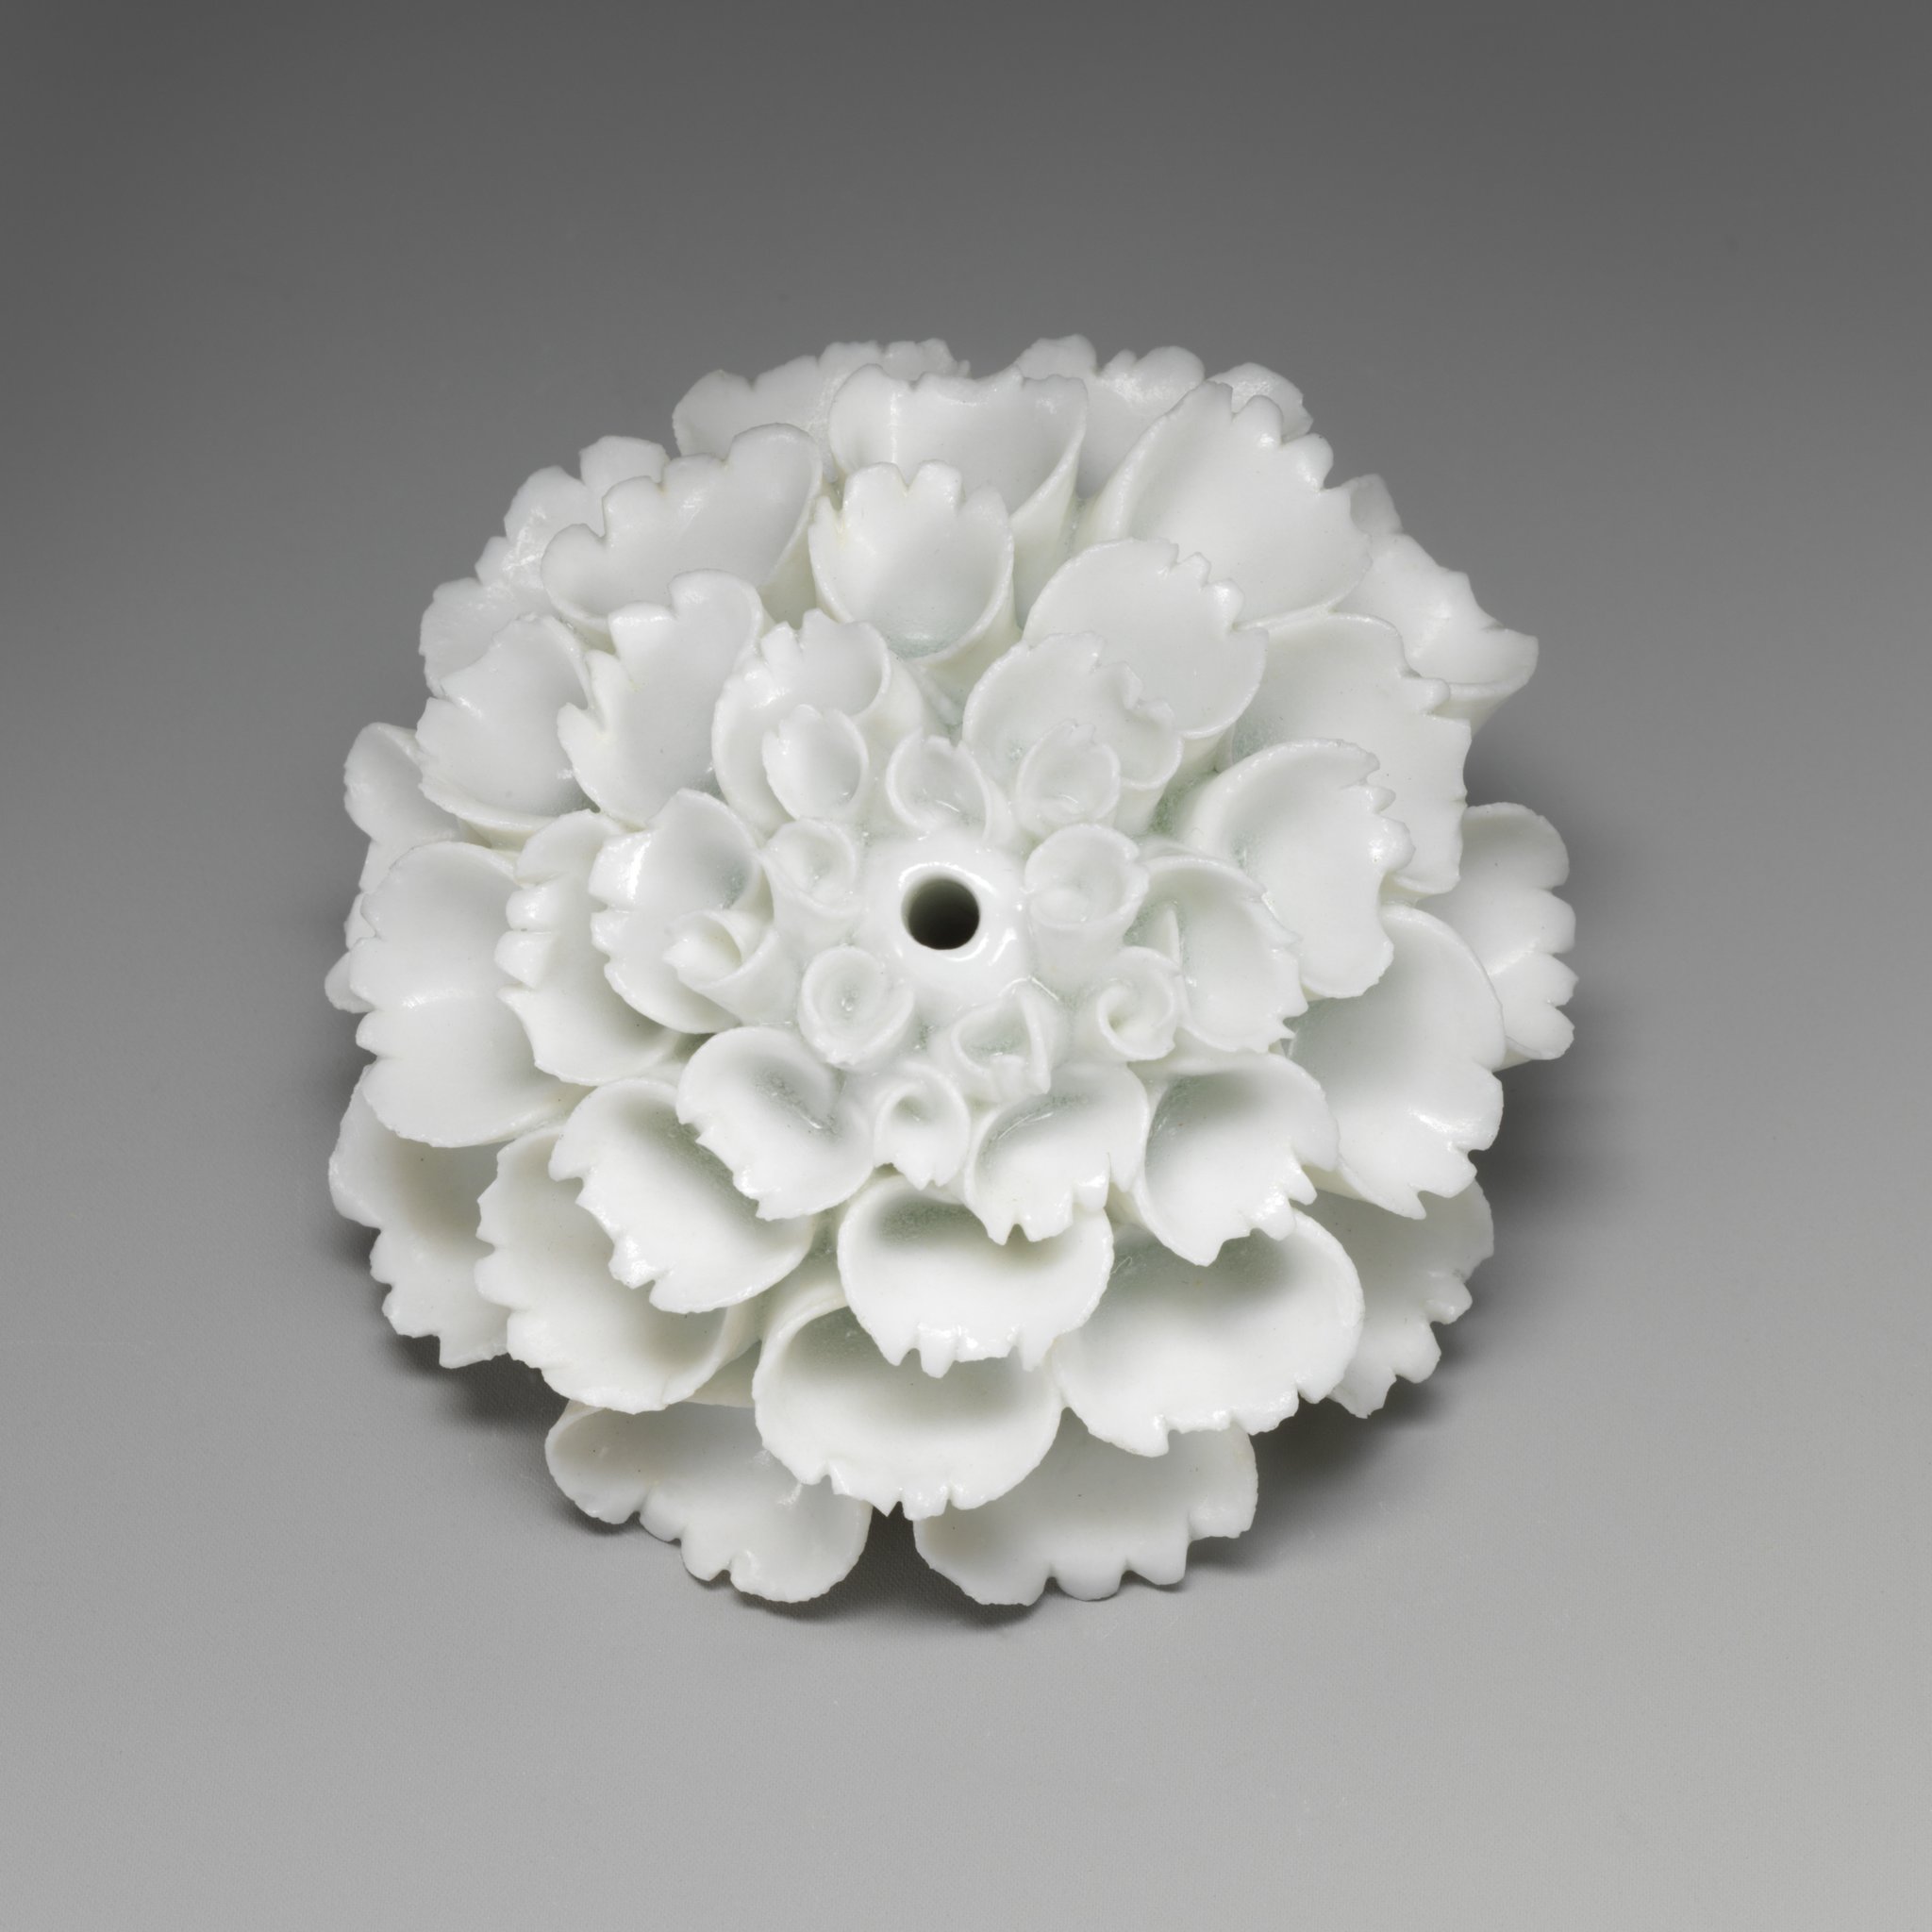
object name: porcelain flower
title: Porcelain flower (one of a set of nine)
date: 1734-1766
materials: soft paste porcelain